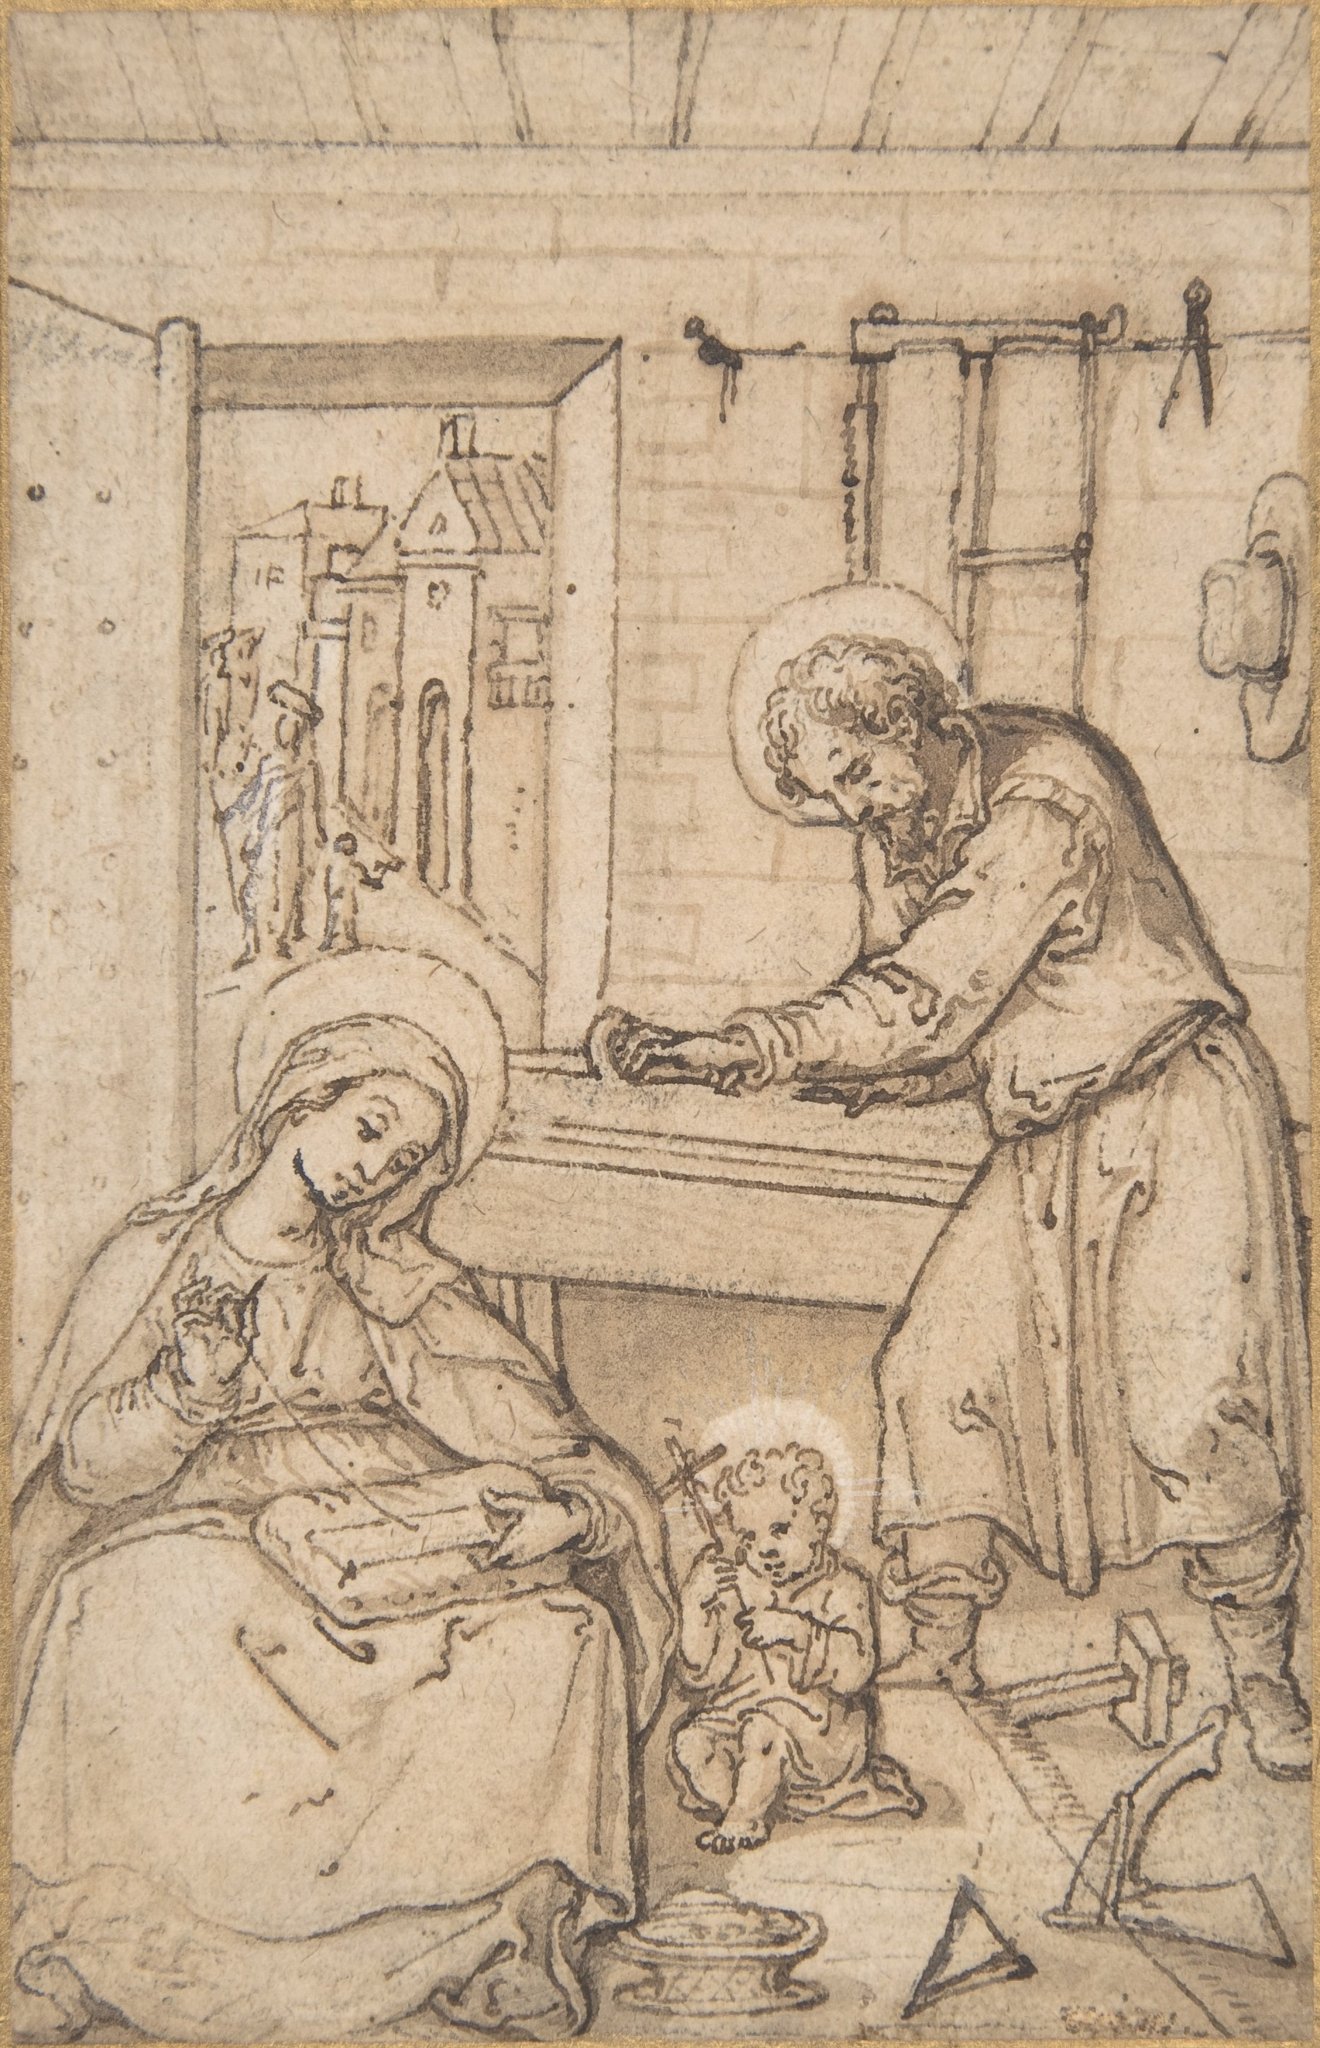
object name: drawing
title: The Childhood of Christ, in the carpenter's shop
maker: hans bol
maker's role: artist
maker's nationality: netherlandish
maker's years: 1534-1593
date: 1534-1593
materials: gouache, ink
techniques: brush, heightening, pen, wash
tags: men,christ,virgin mary,sewing,tools